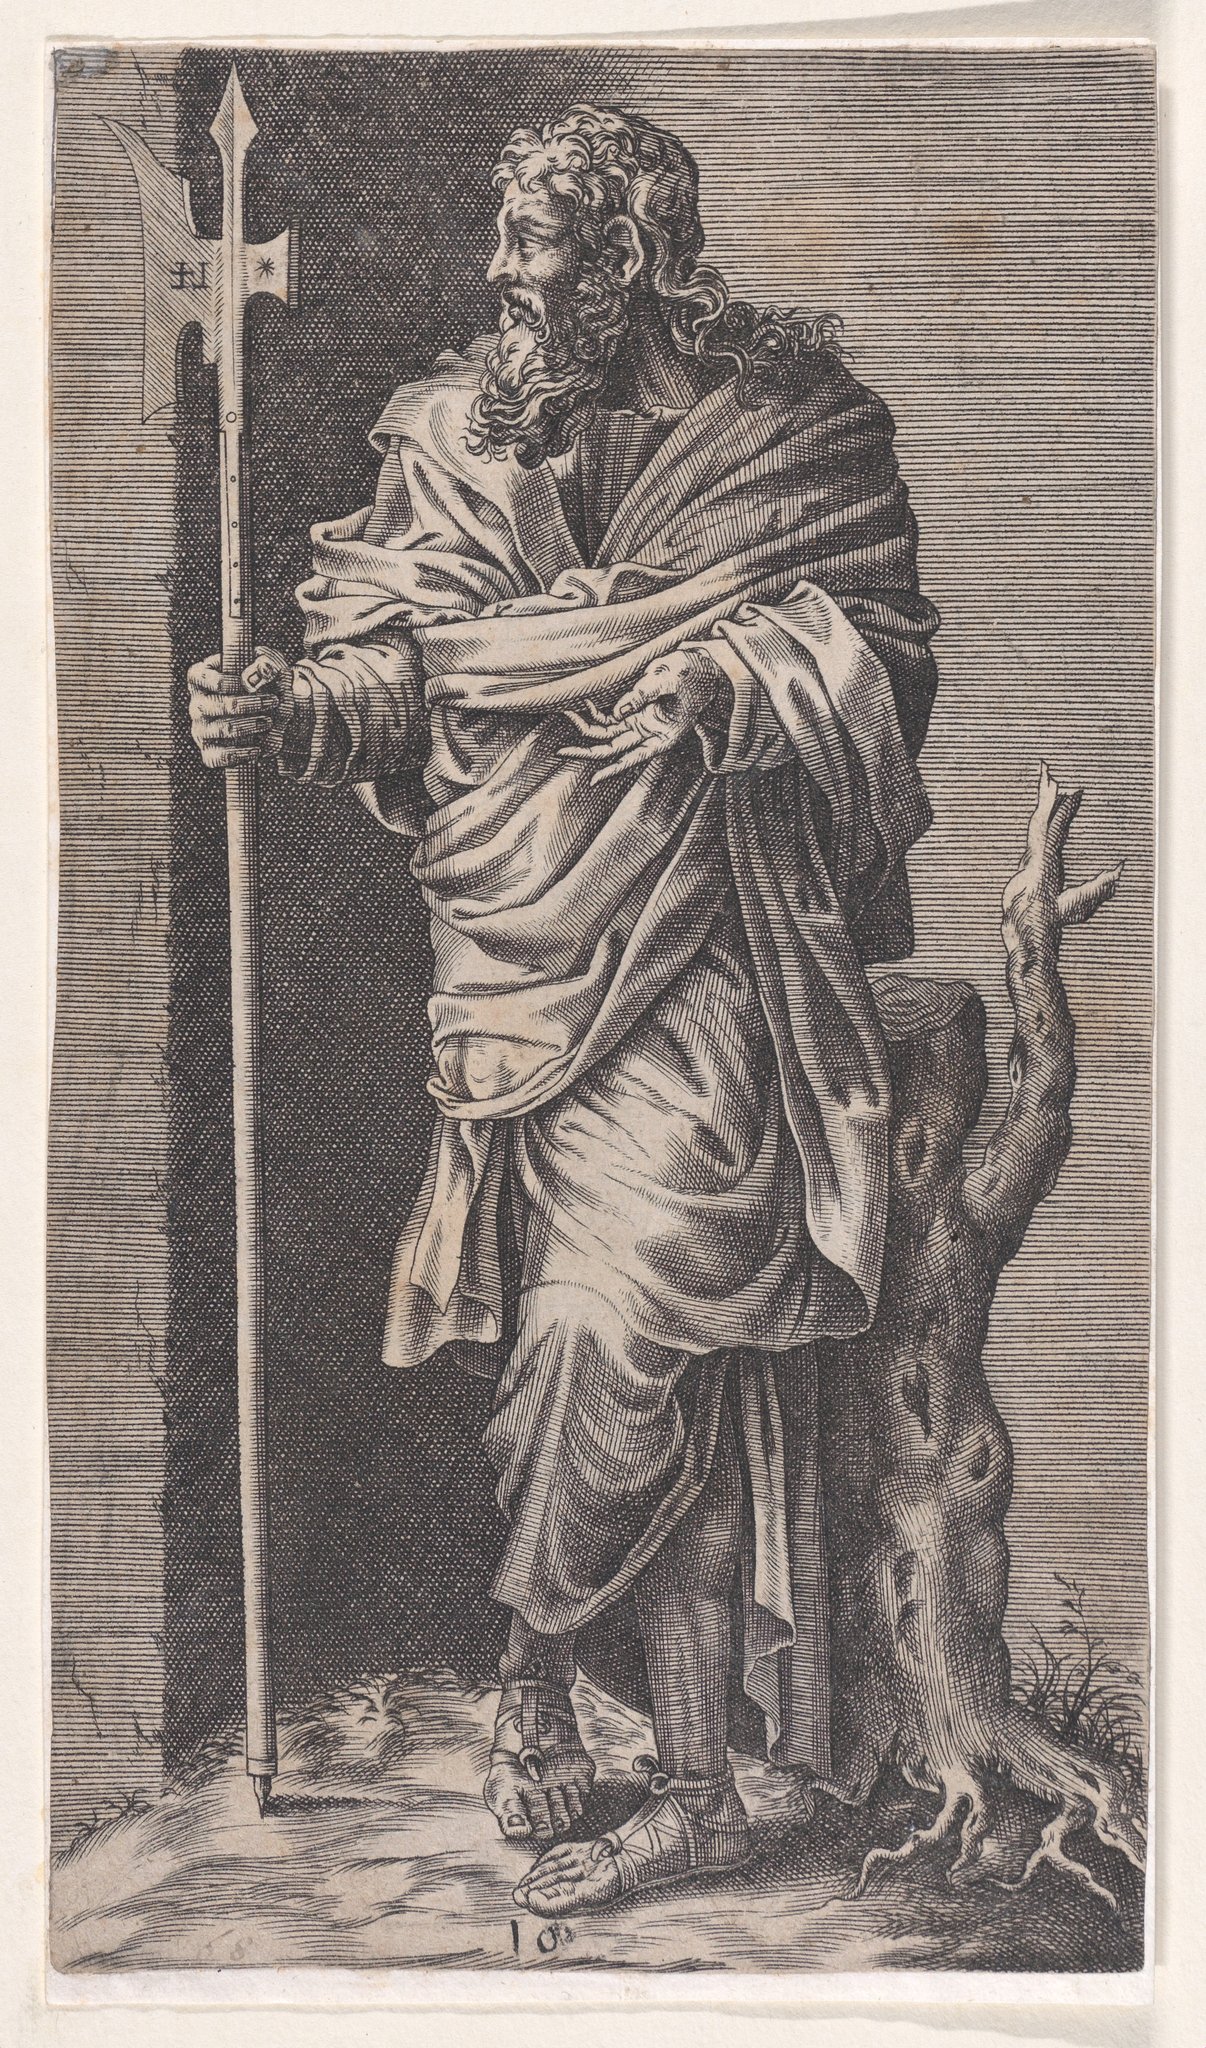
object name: print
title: St. Thomas, from "Christ and the Apostles"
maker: lambert suavius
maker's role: artist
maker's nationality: netherlandish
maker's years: 1510-1576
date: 1530-1576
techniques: backing, engraving